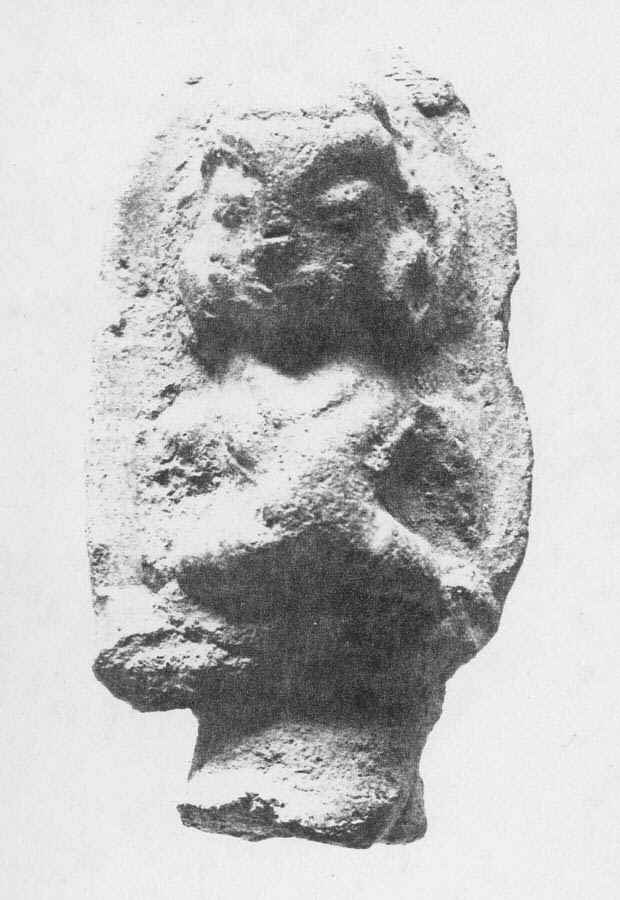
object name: relief fragment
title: Relief of a Female Deity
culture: indian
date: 1-500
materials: terracotta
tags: shunga,goddess